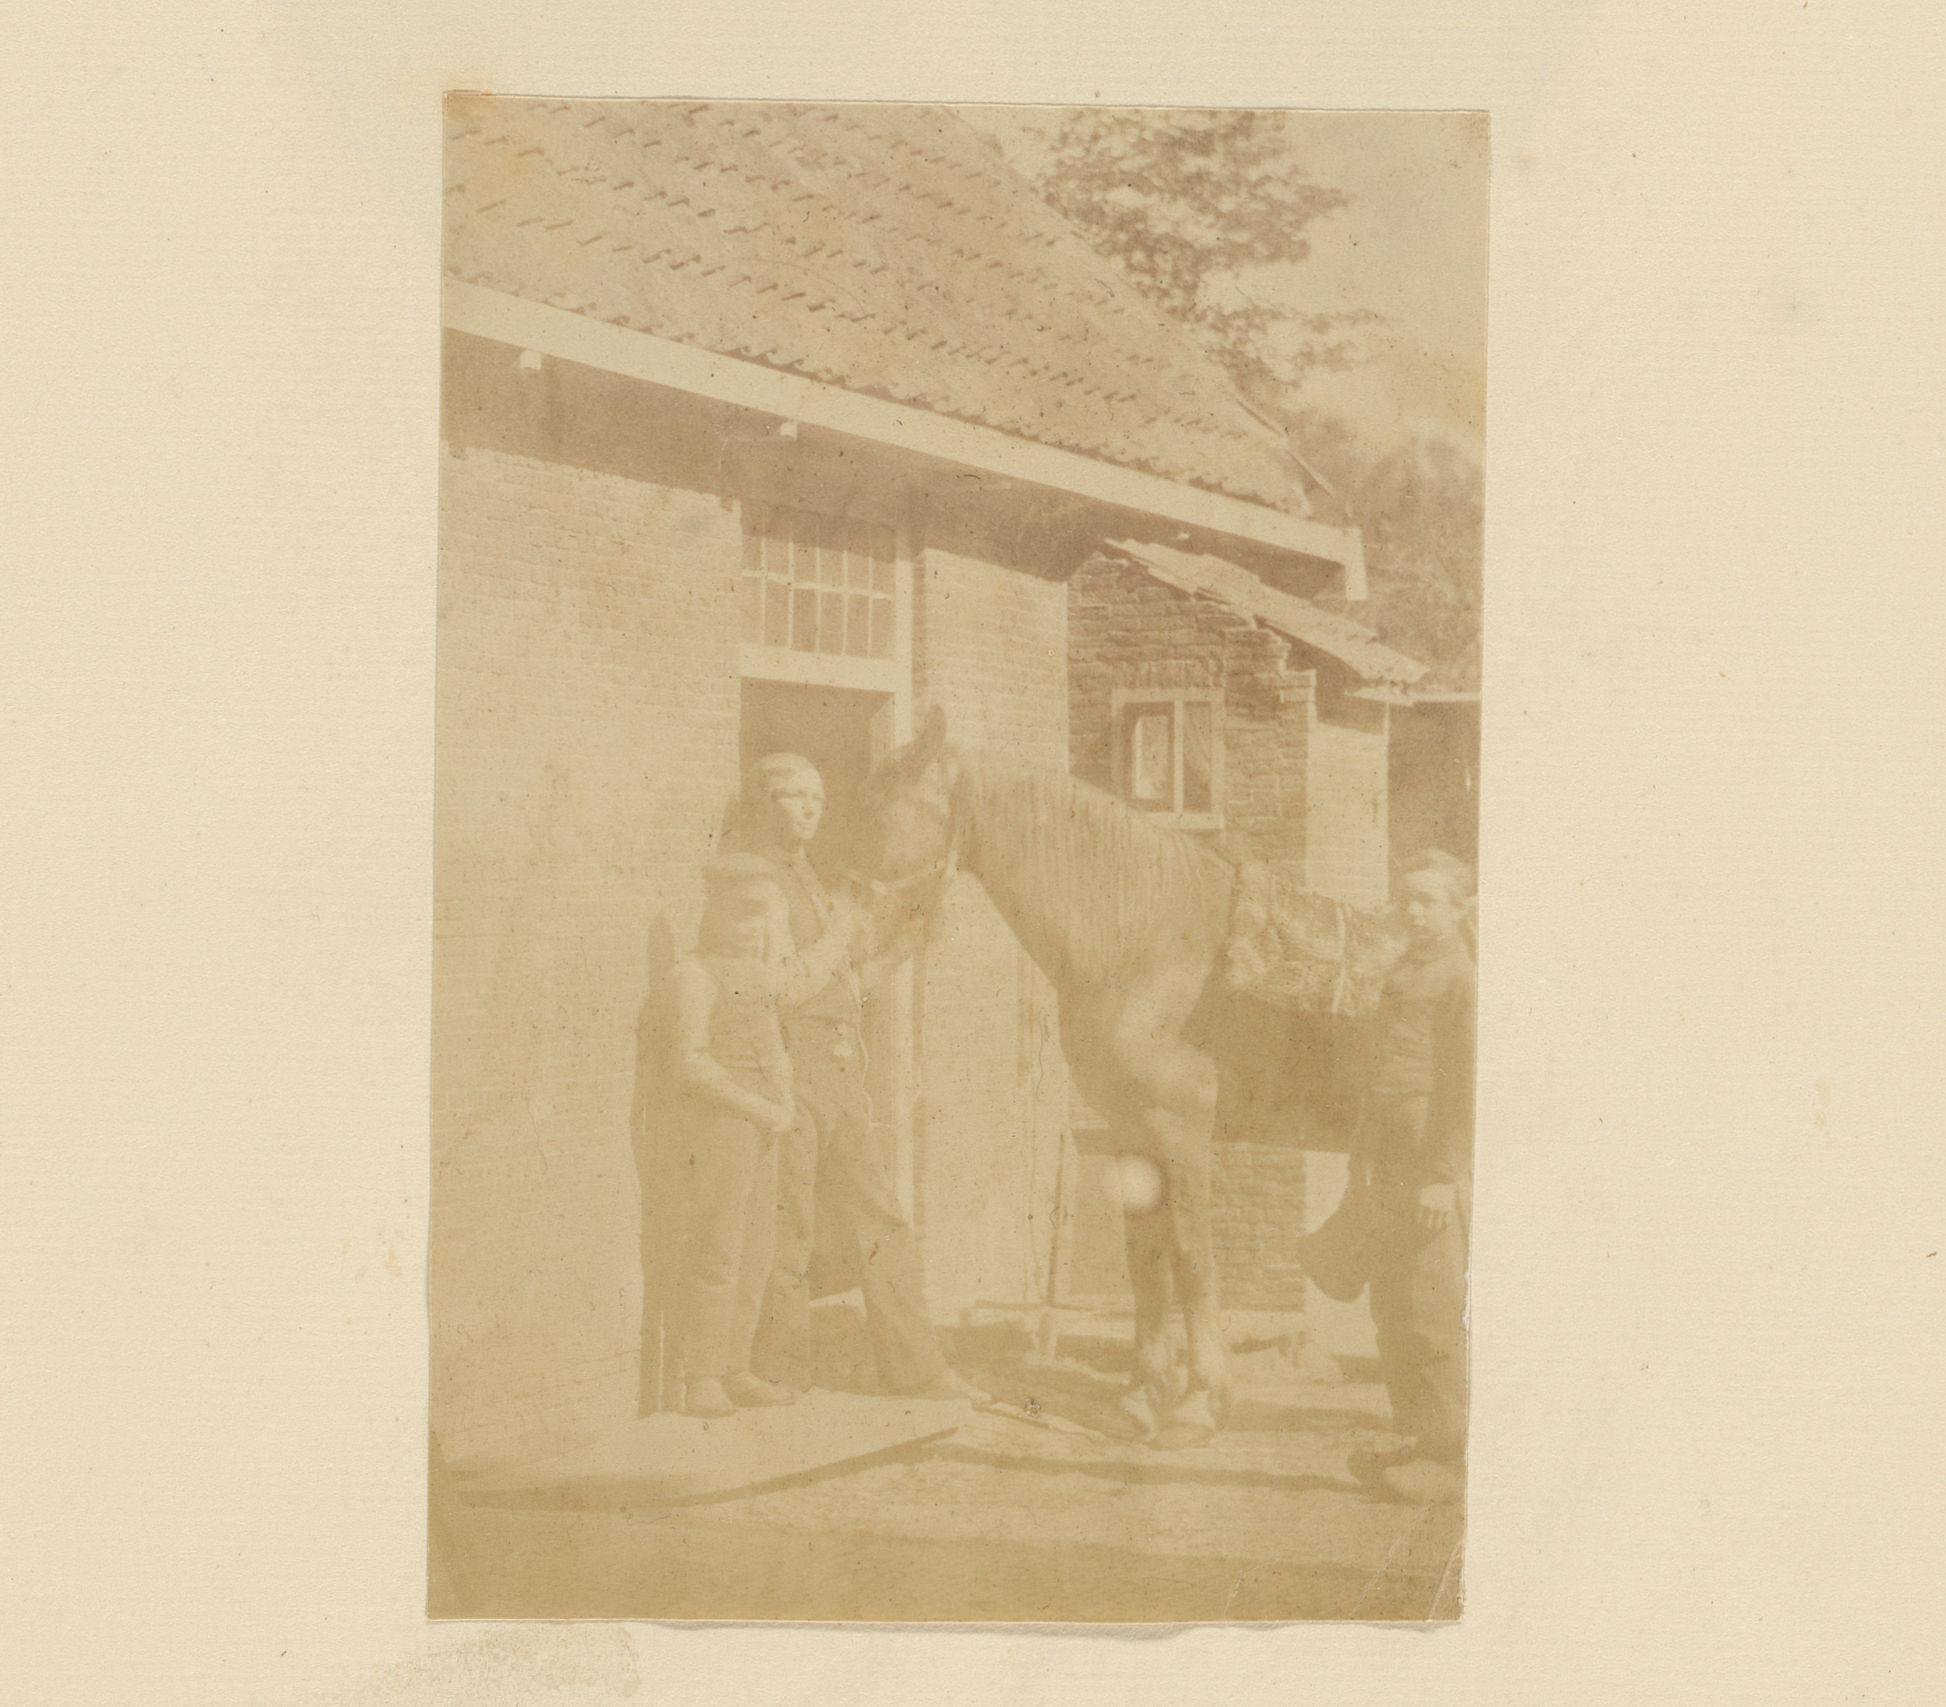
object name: photograph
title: Portret van een man met paard en twee jongens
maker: eduard isaac asser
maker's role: amateurfotograaf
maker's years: 1809-1894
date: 1850-1860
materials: cardboard, paper, photographic support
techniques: salted paper print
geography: amsterdam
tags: horse